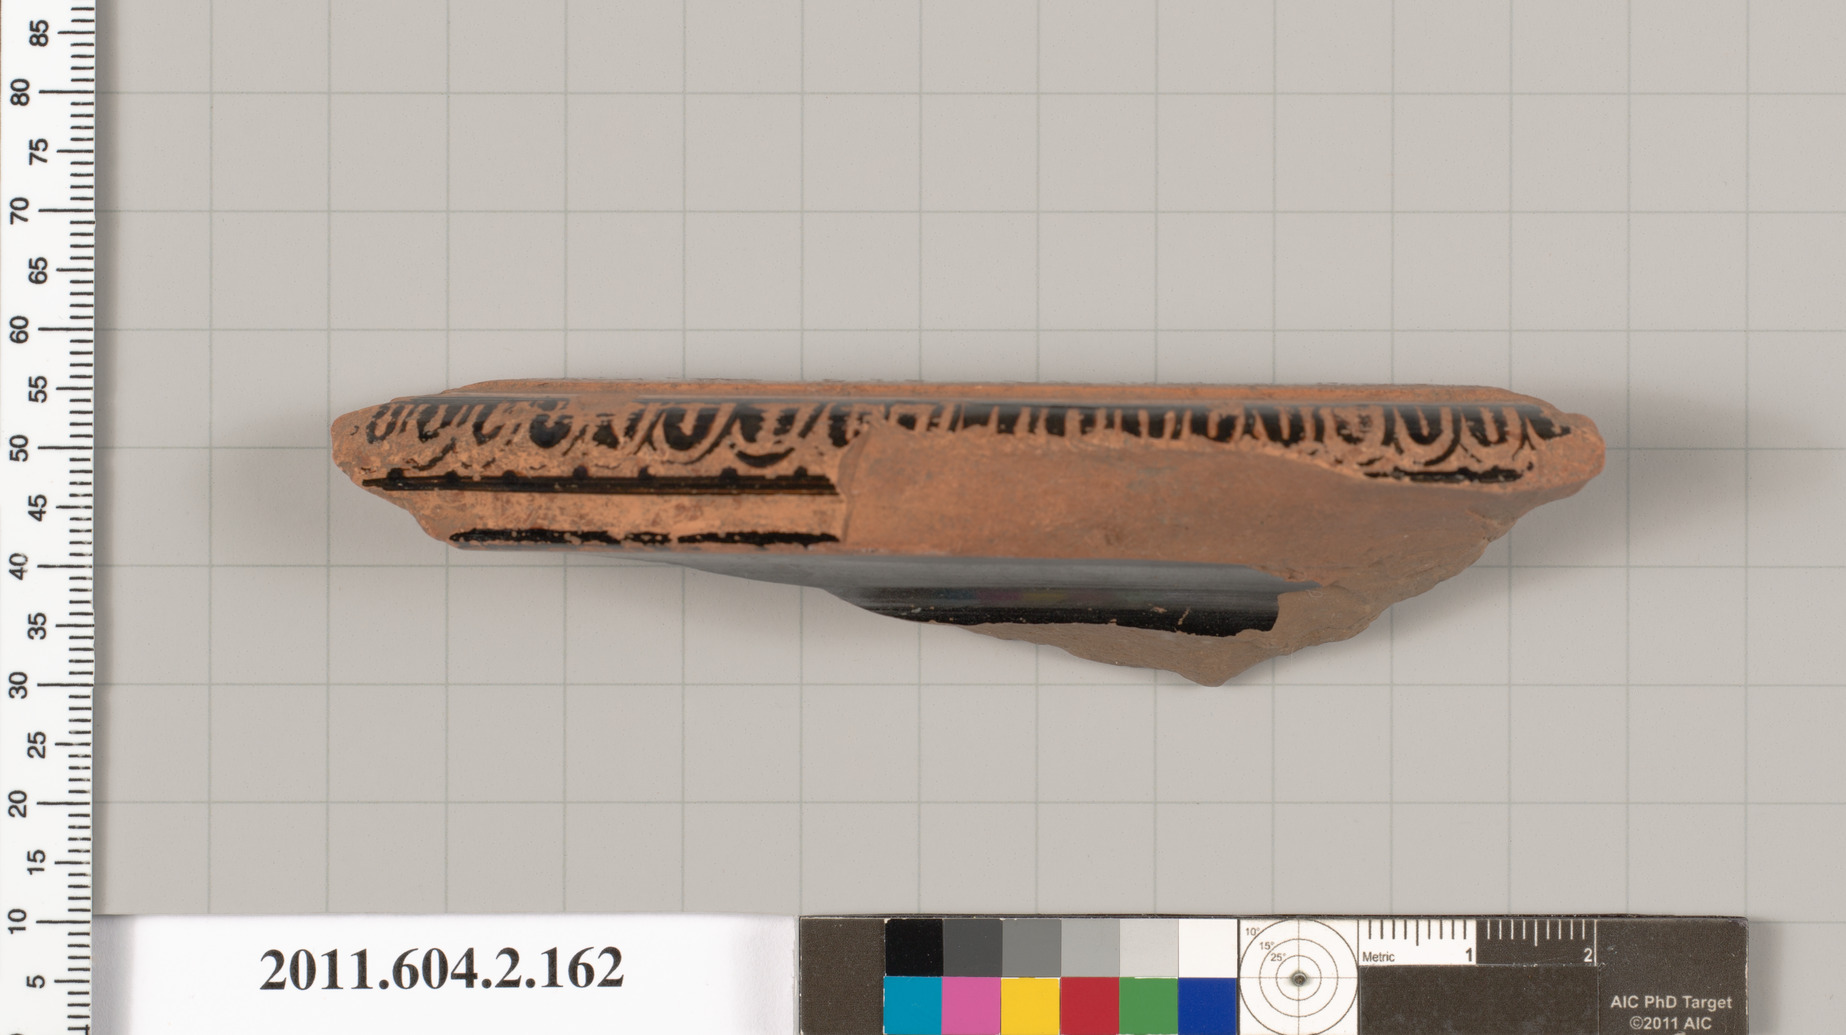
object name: stamnos fragment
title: Terracotta fragment of a stamnos (jar)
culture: greek, attic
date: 470-460 BCE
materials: terracotta